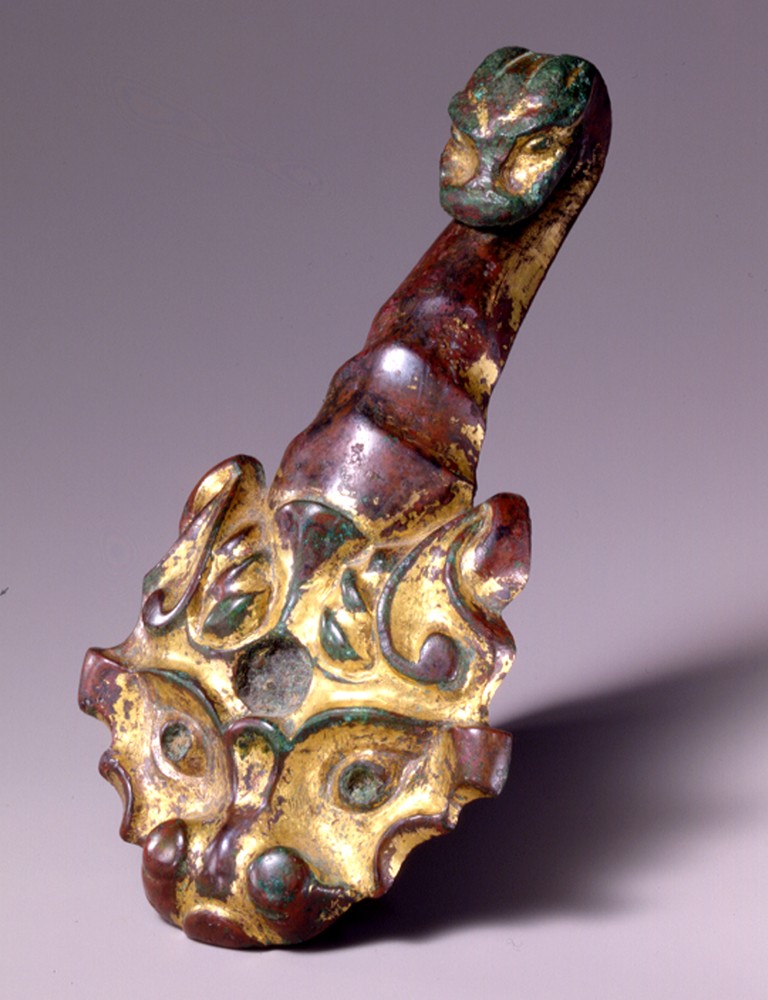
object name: garment hook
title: Hook with Horned Feline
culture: north chinese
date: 300-201 BCE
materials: bronze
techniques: gilding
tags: animals